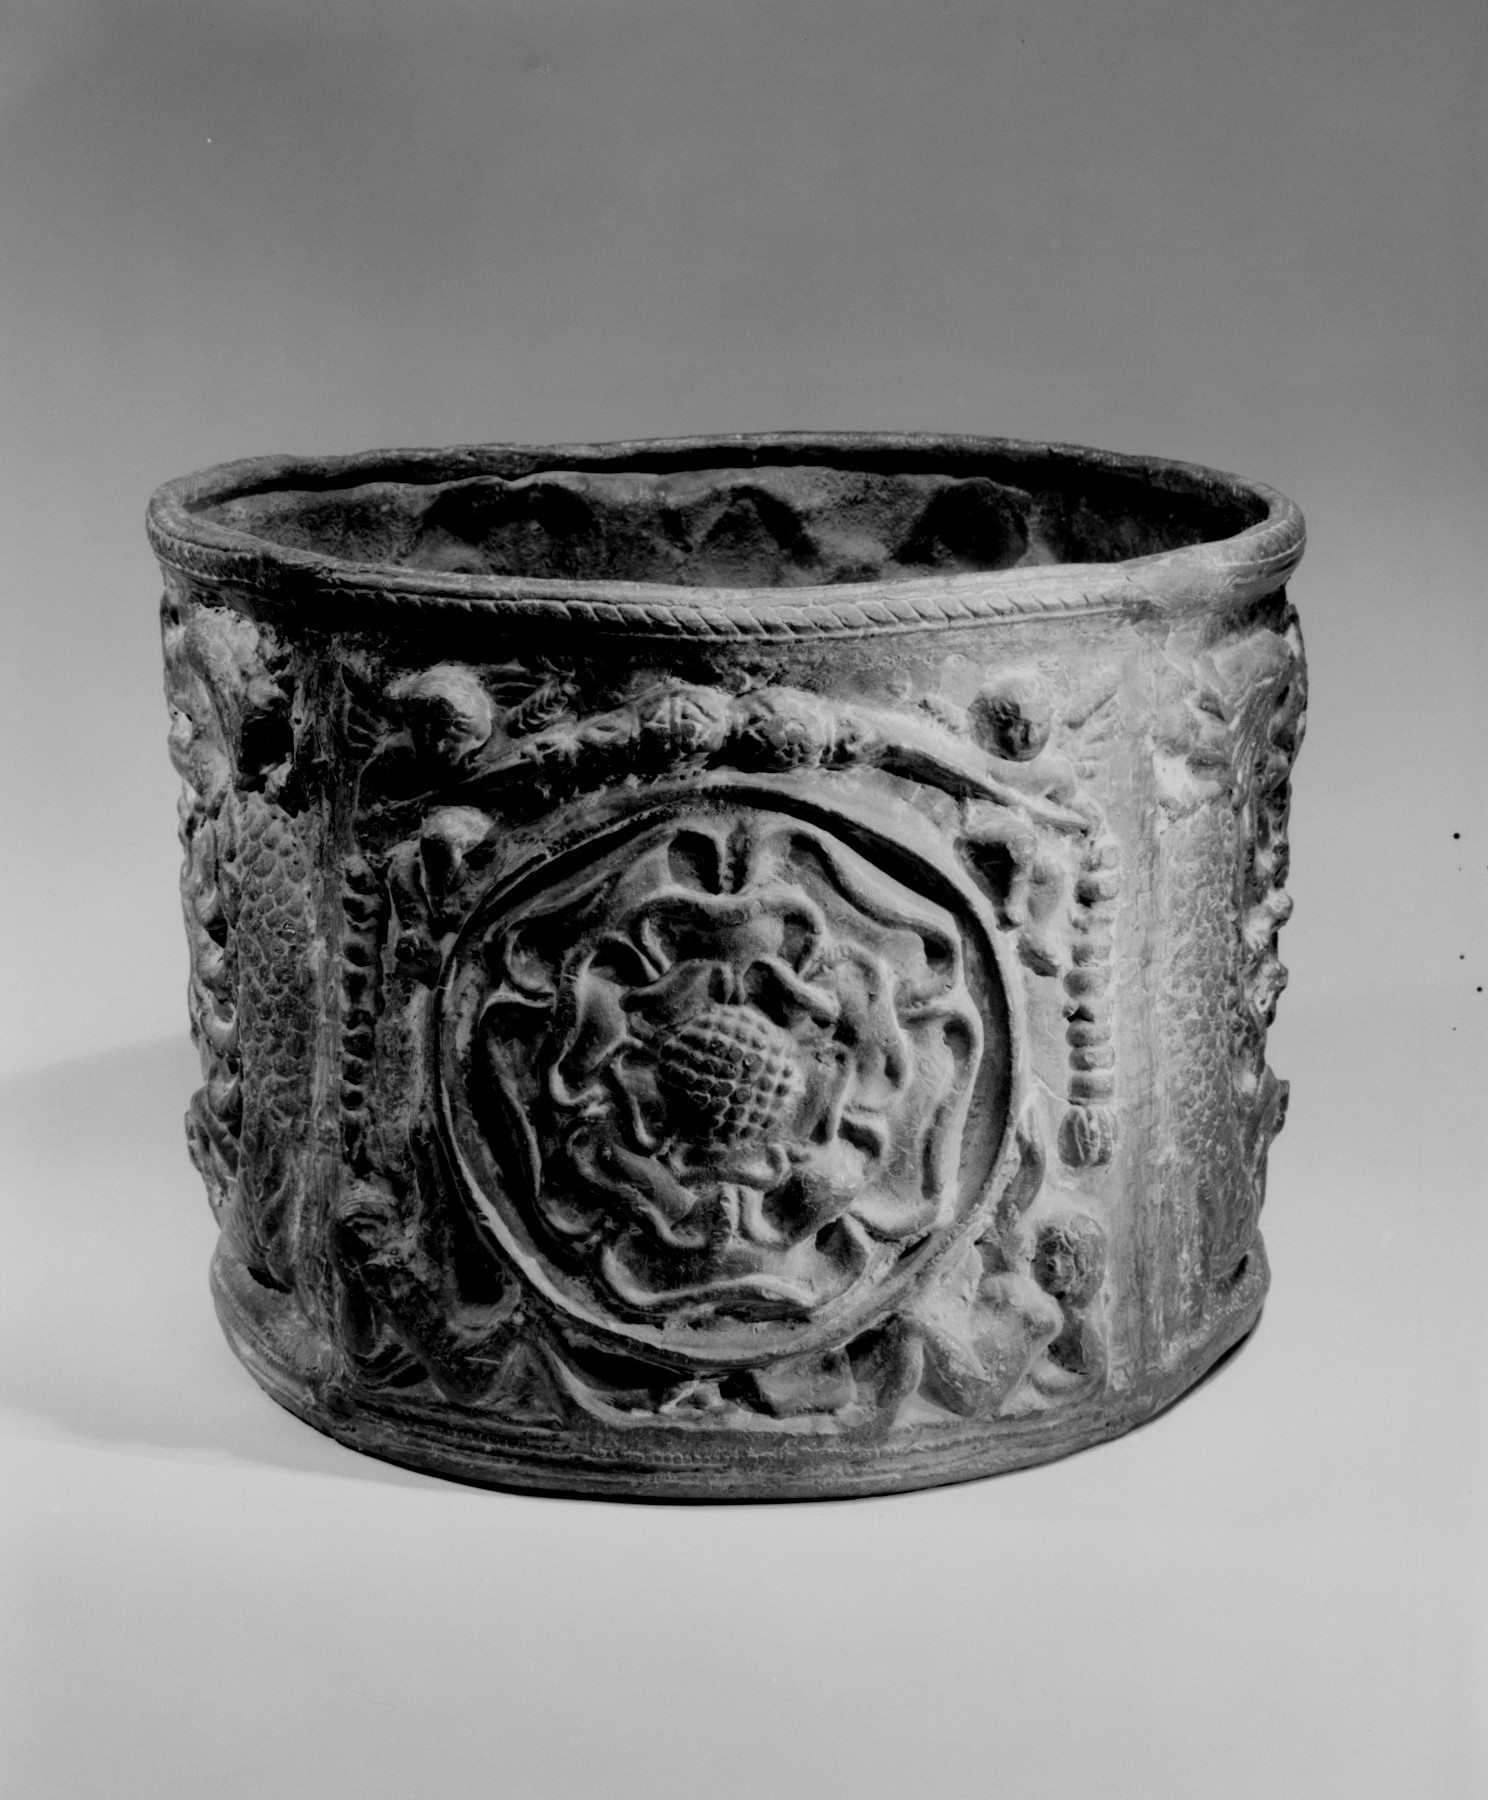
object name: cistern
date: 1527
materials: lead